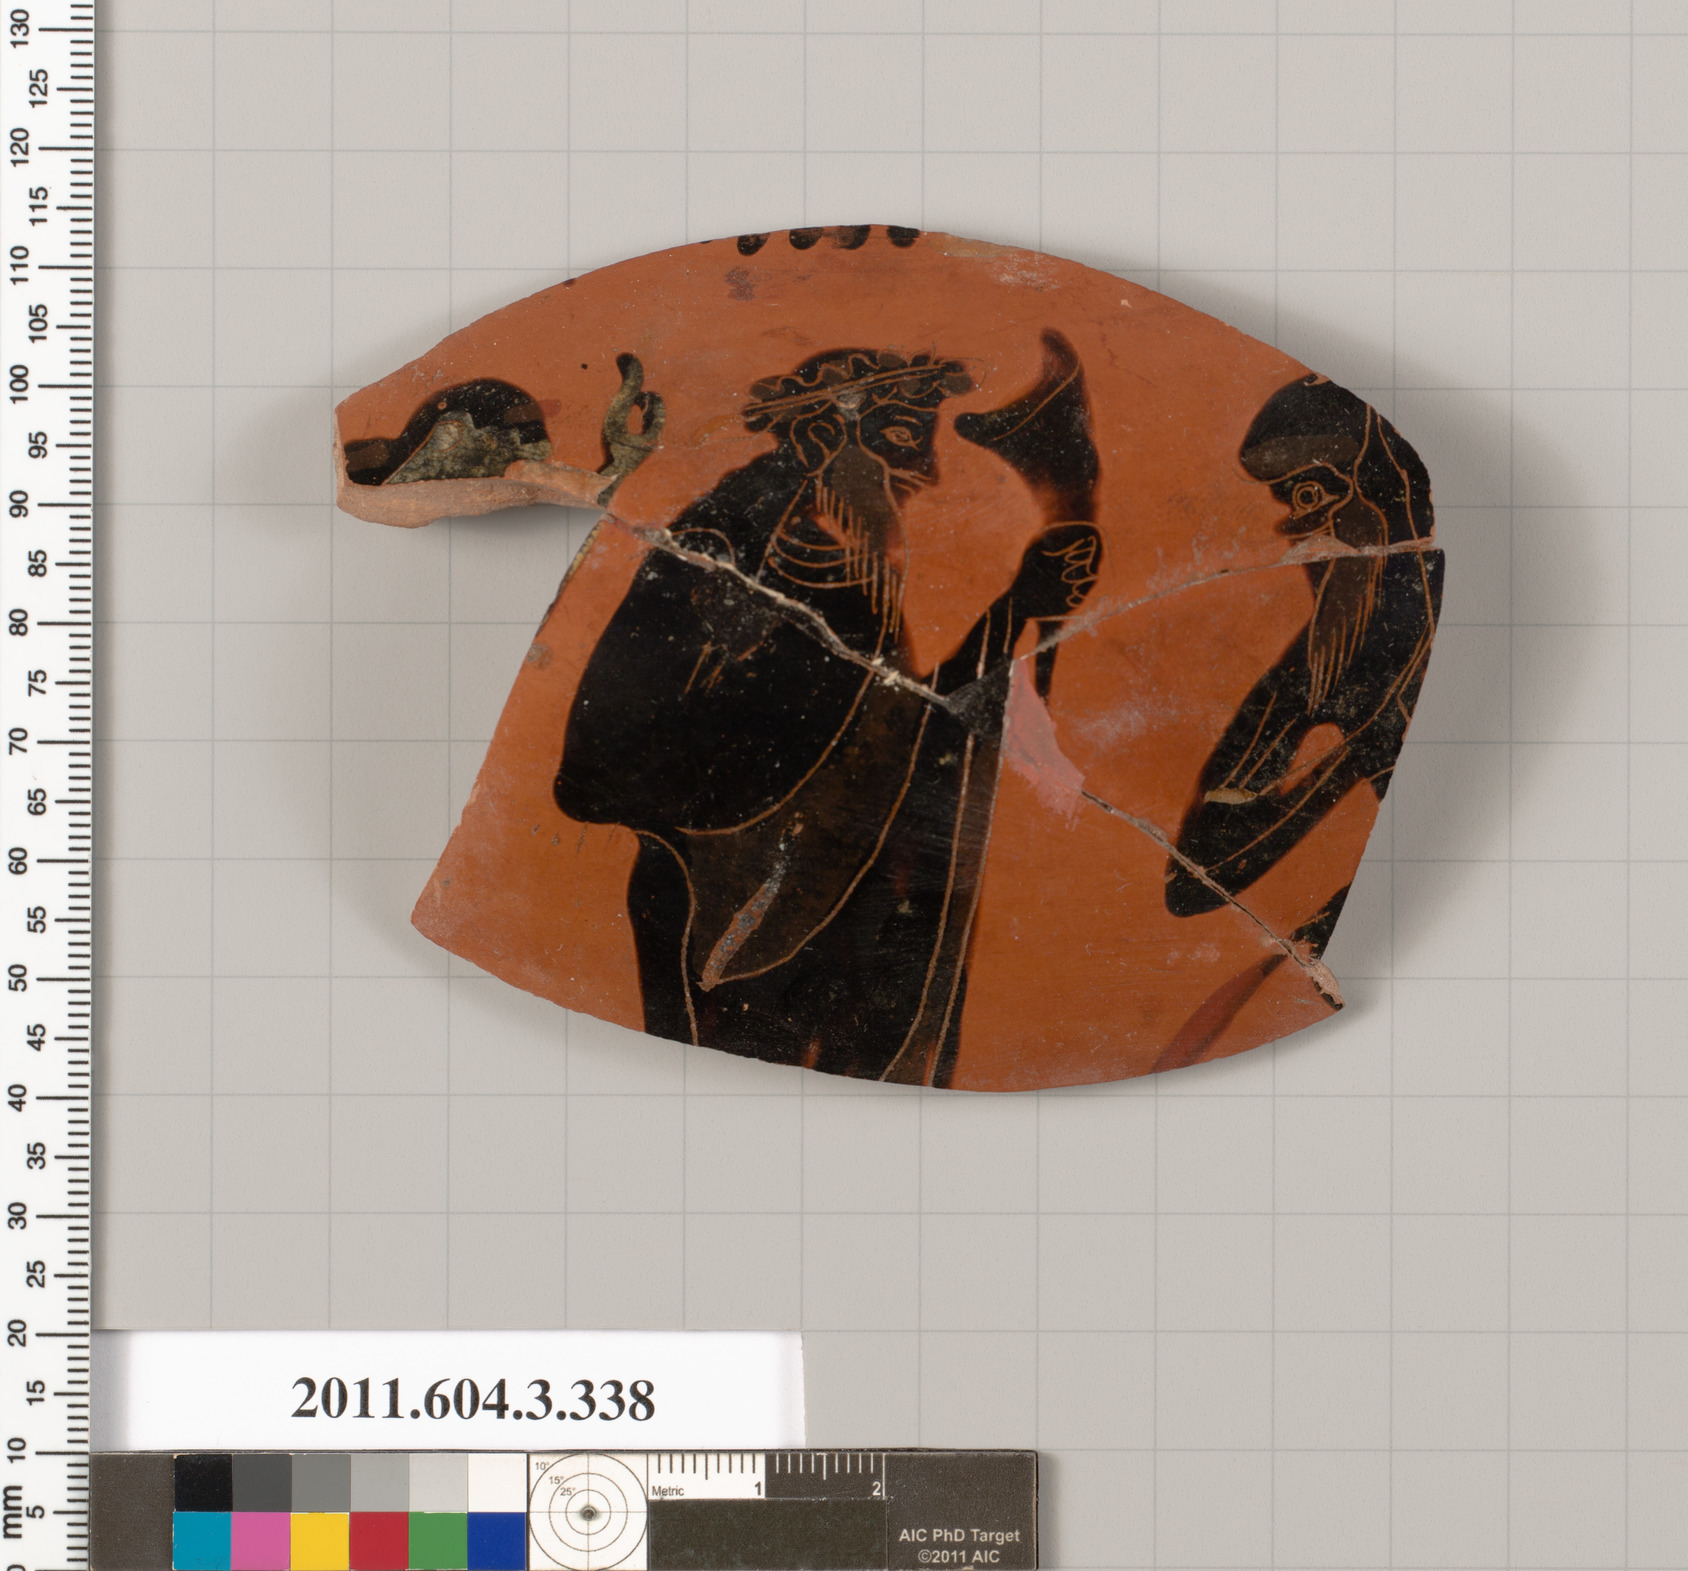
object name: neck amphora fragment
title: Terracotta fragment of a neck-amphora (jar)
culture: greek, attic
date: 530-520 BCE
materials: terracotta